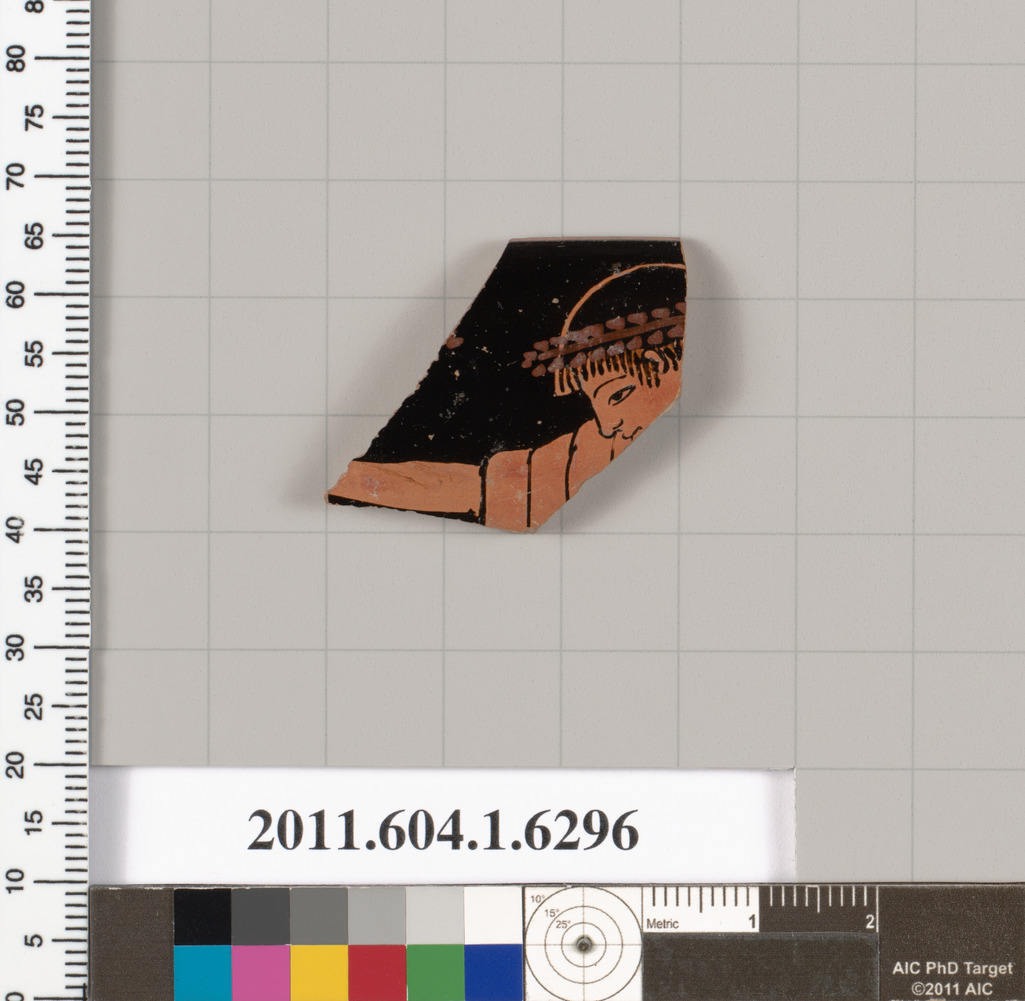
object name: kylix fragment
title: Terracotta rim fragment of a kylix (drinking cup)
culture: greek, attic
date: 500-480 BCE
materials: terracotta